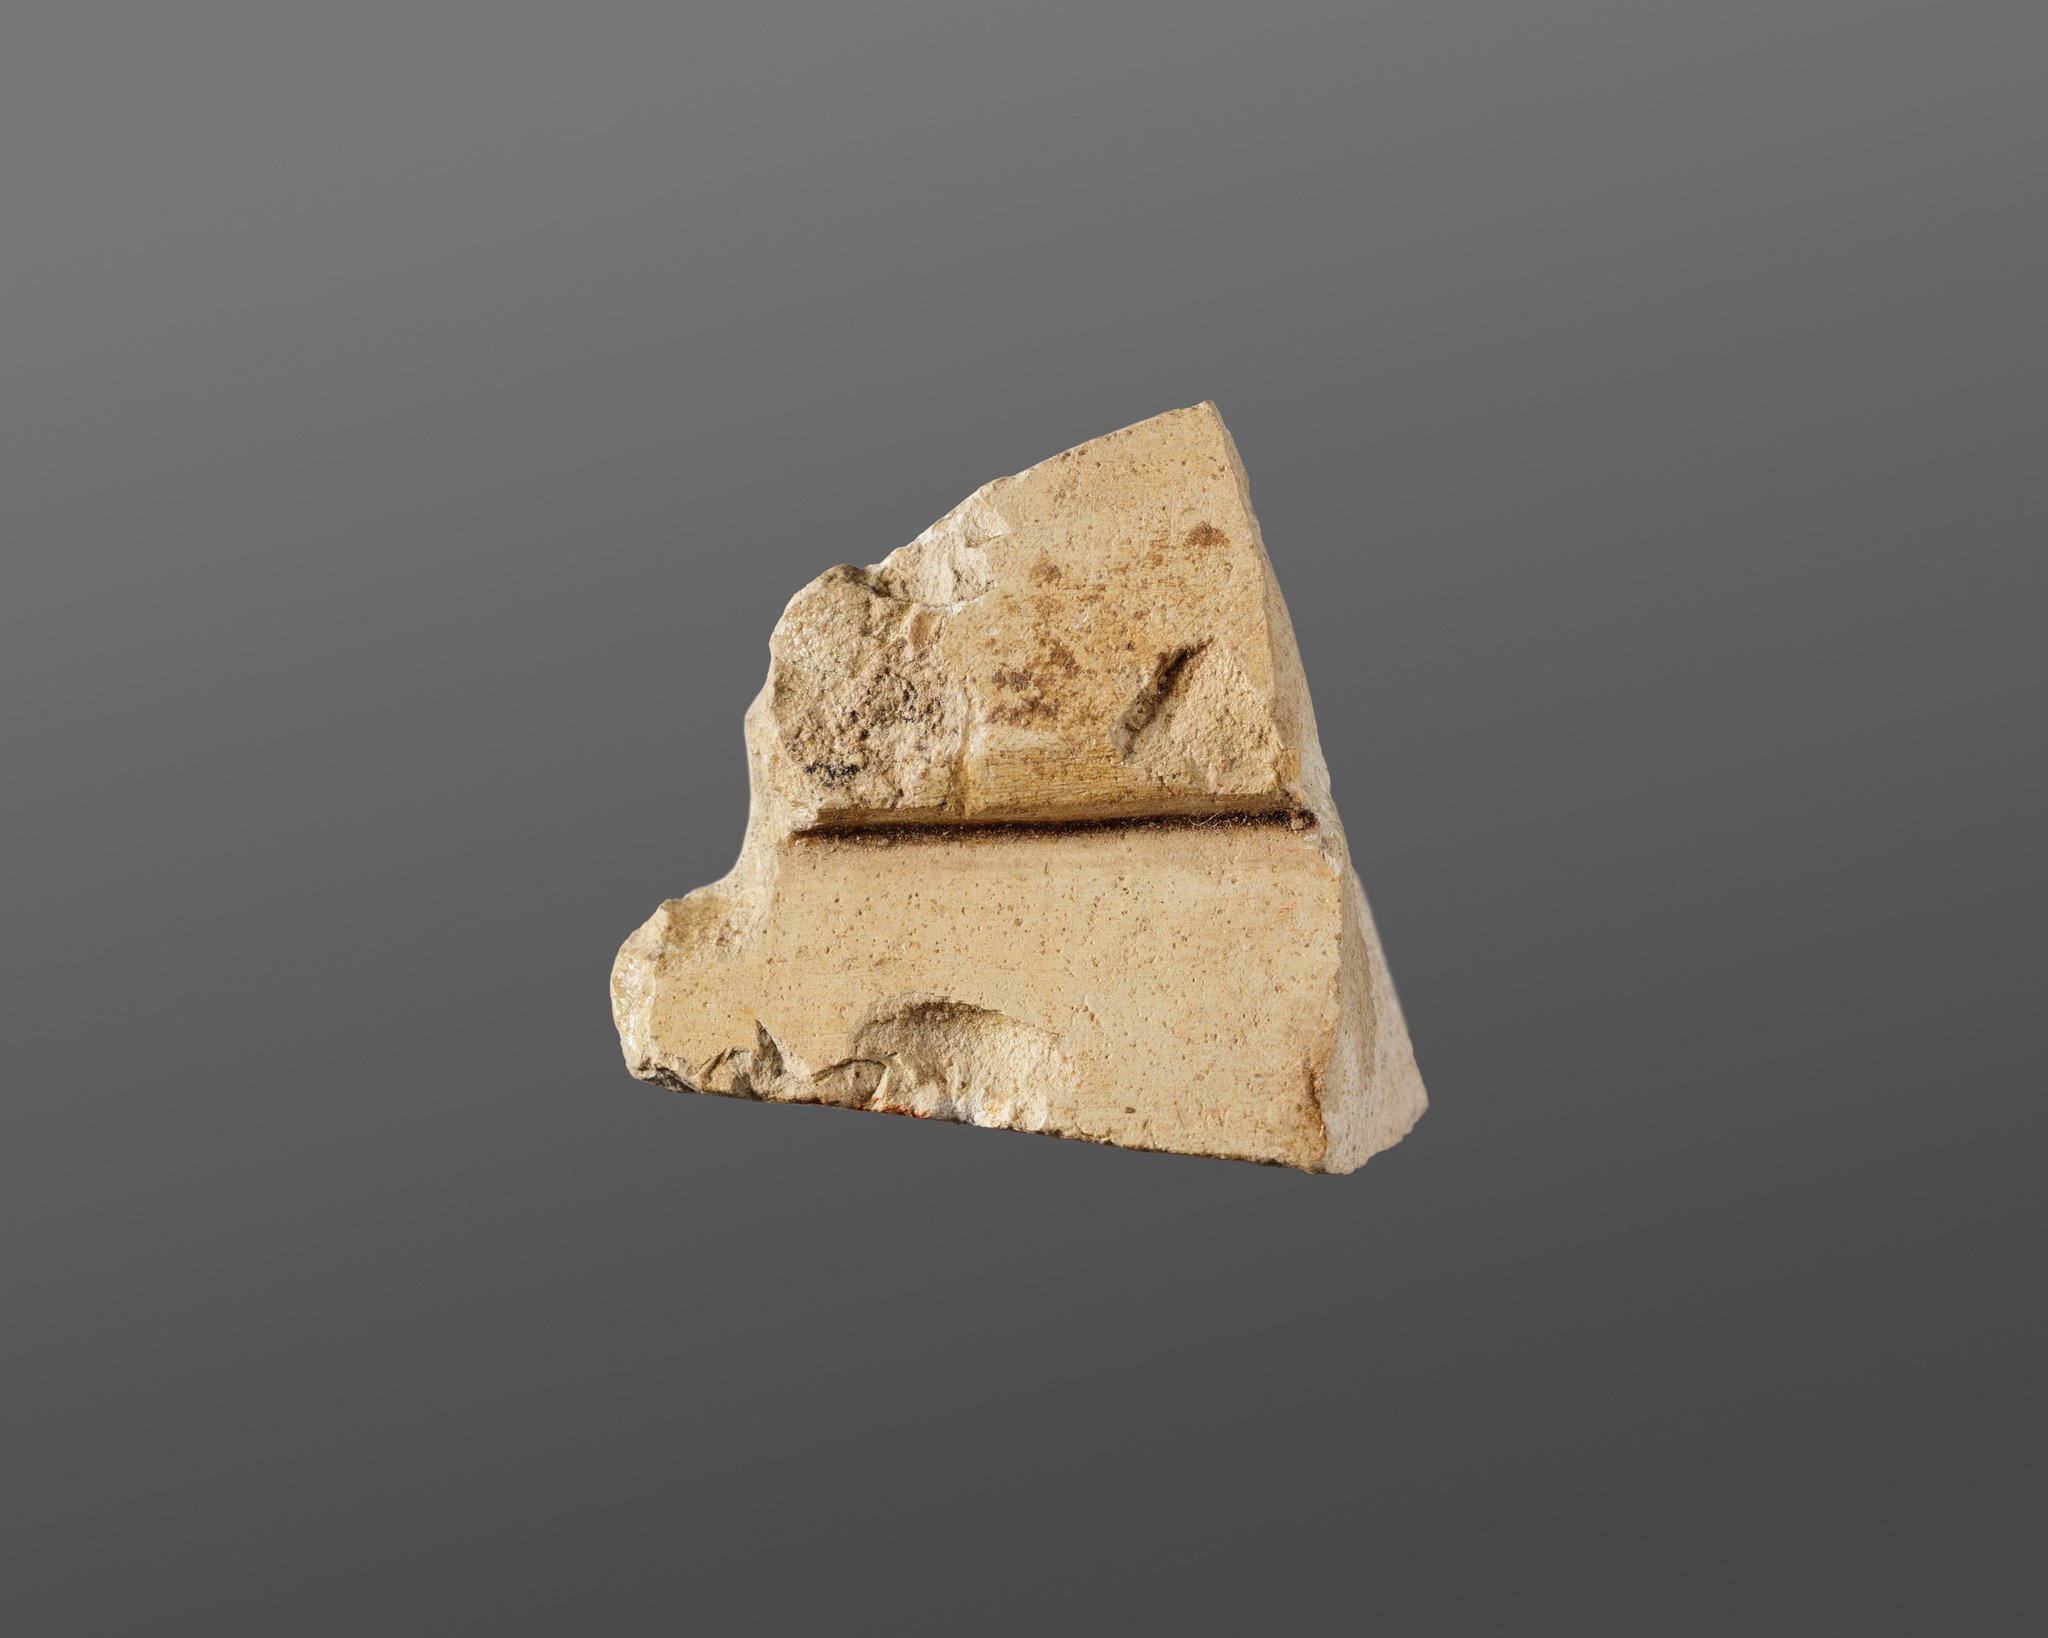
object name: relief fragment, tomb of neferu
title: Relief fragment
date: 2051-2030 BCE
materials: limestone, paint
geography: egypt